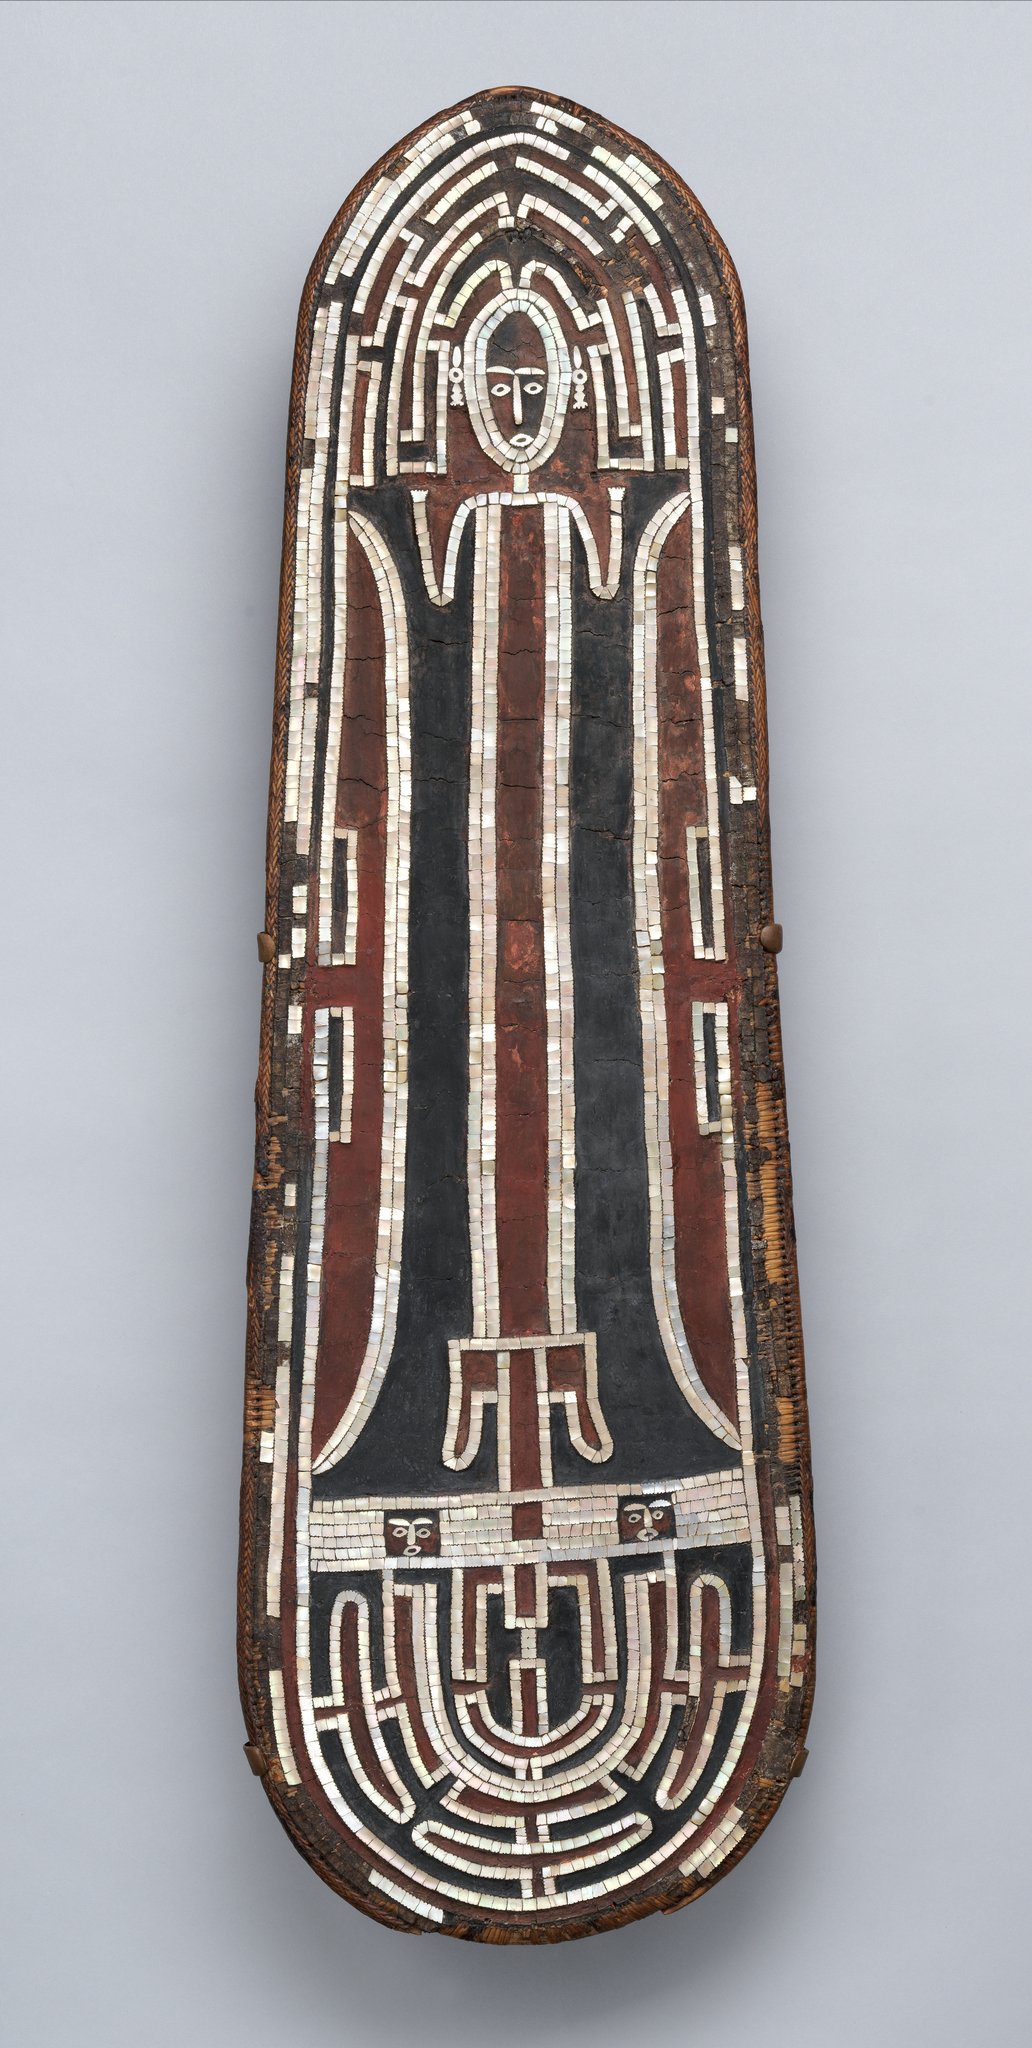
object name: shield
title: Shield (Grere'o)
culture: solomon islands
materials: fiber, paste, pigment, shell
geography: solomon islands